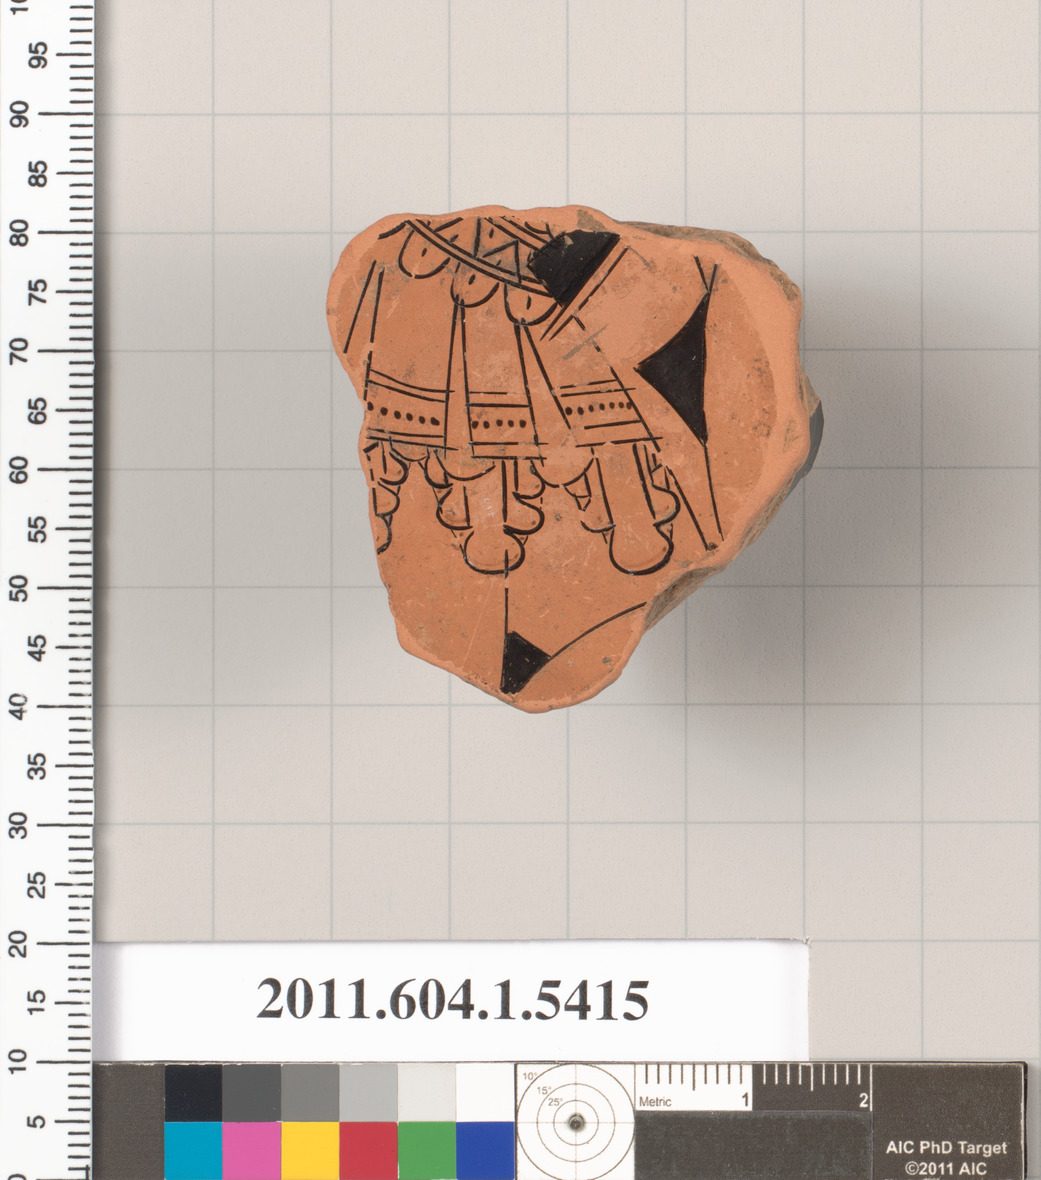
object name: kylix fragment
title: Terracotta fragment of a kylix (drinking cup)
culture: greek, attic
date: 510-500 BCE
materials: terracotta